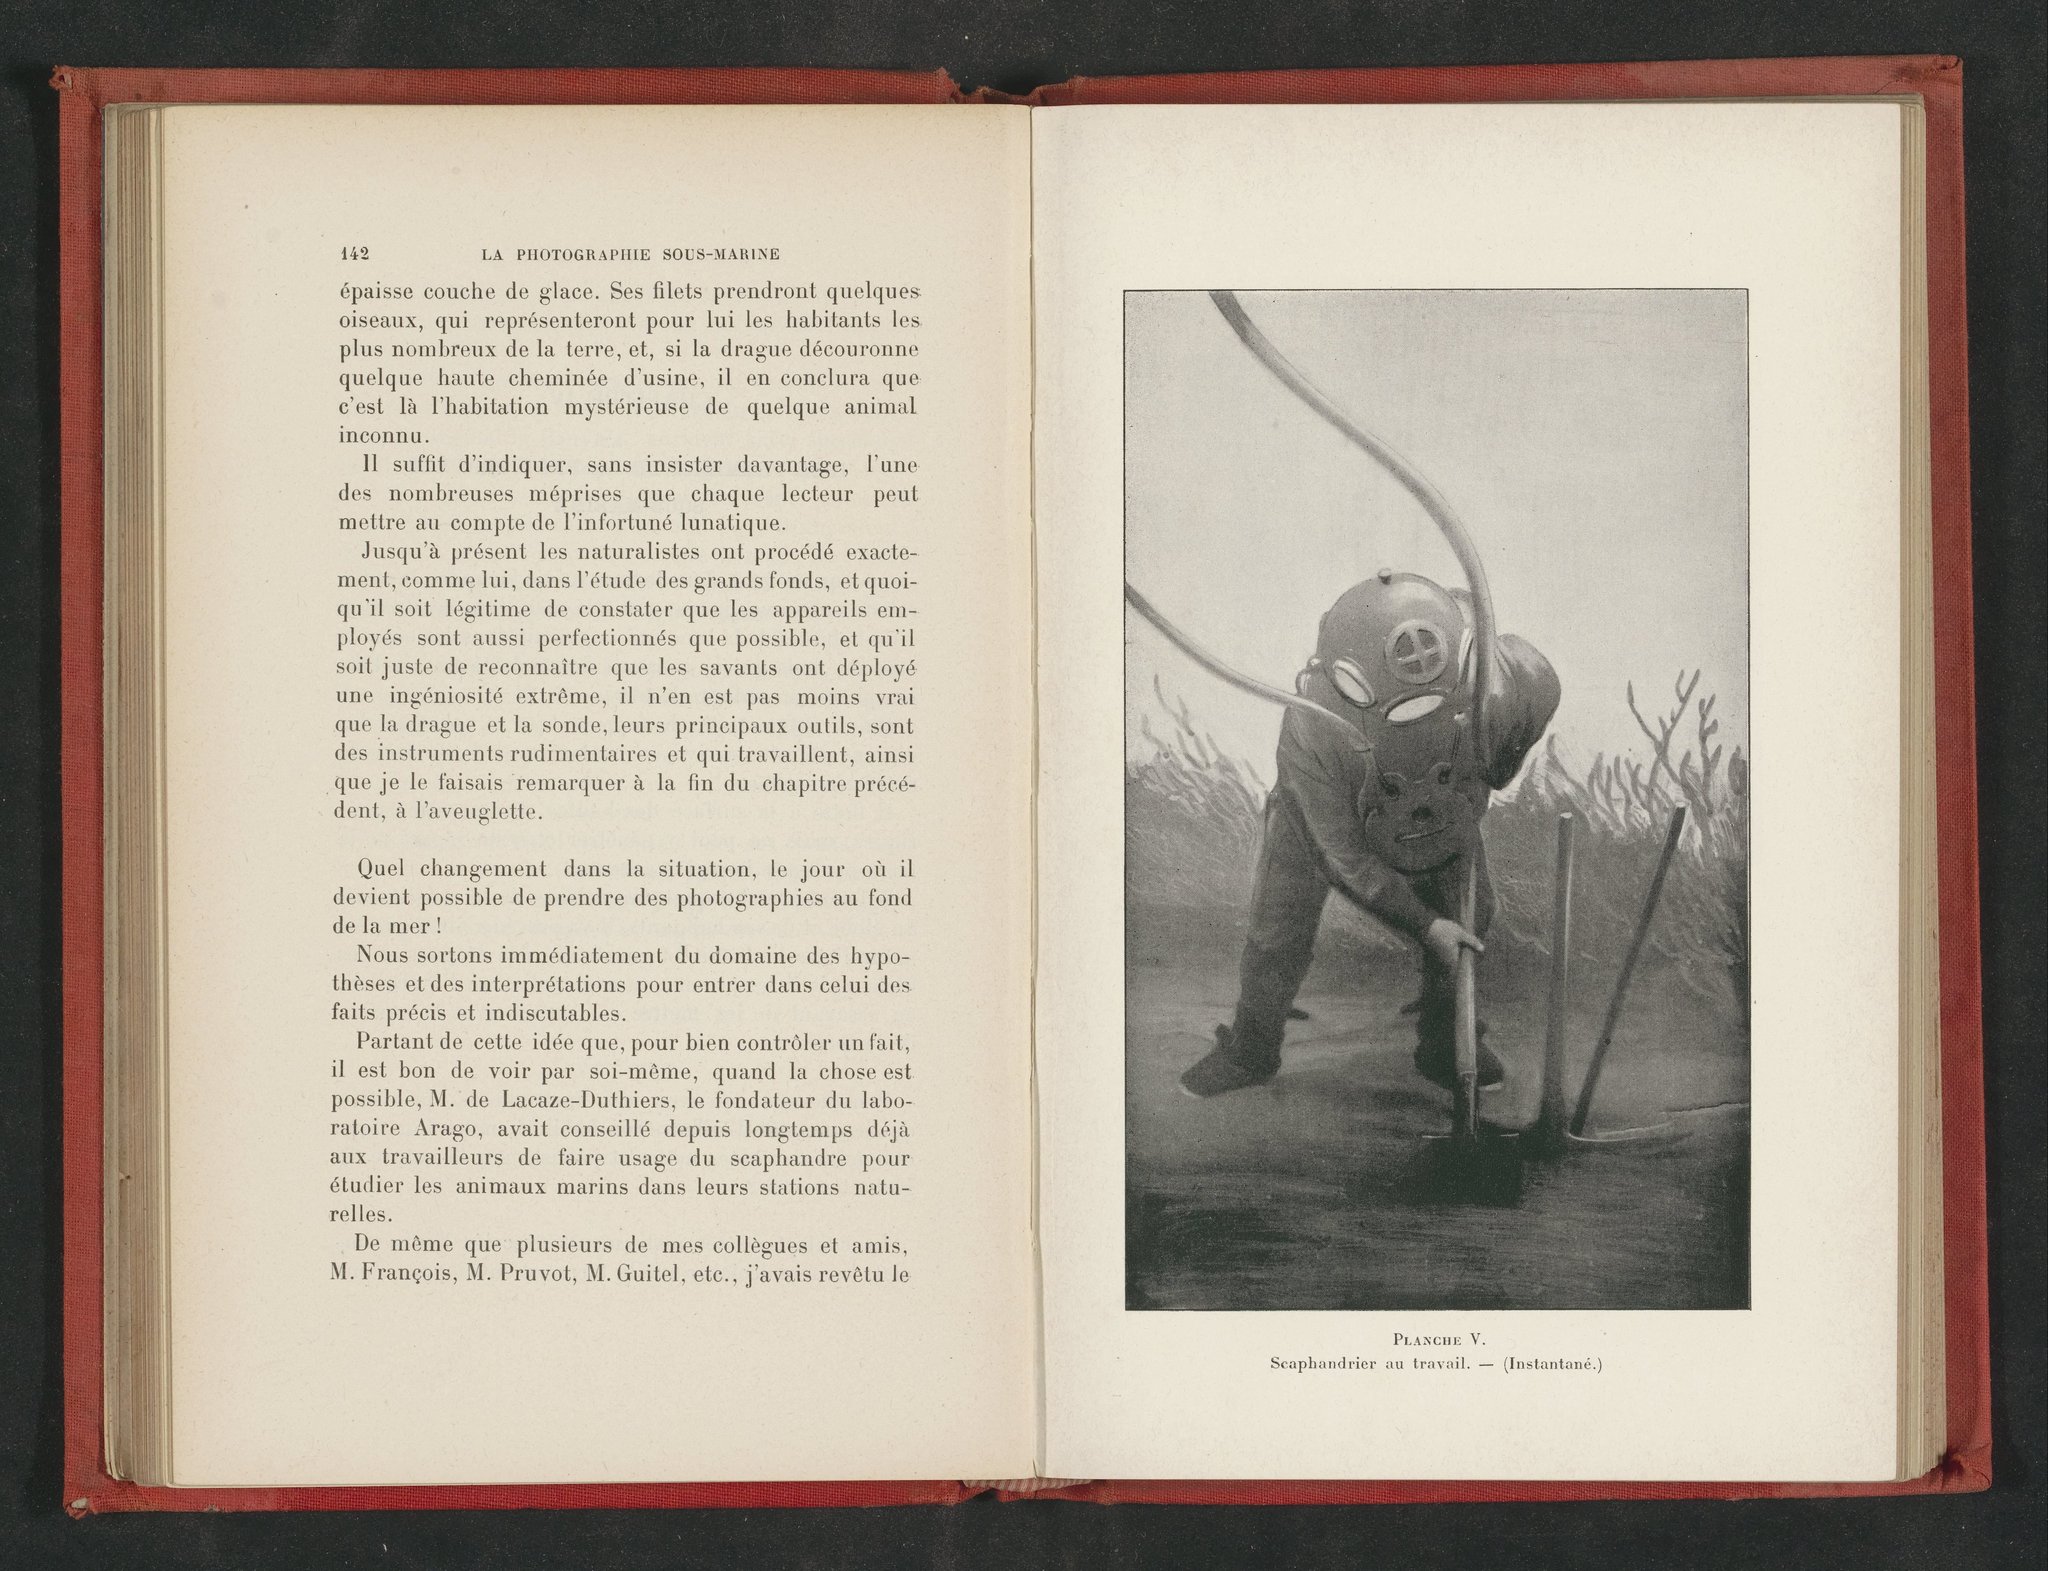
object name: page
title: Fotoreproductie van een schilderij, voorstellende een duiker met een schep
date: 1890-1900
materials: paper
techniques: autotype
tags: deep-sea diving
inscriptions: number: ‘Planche V.’